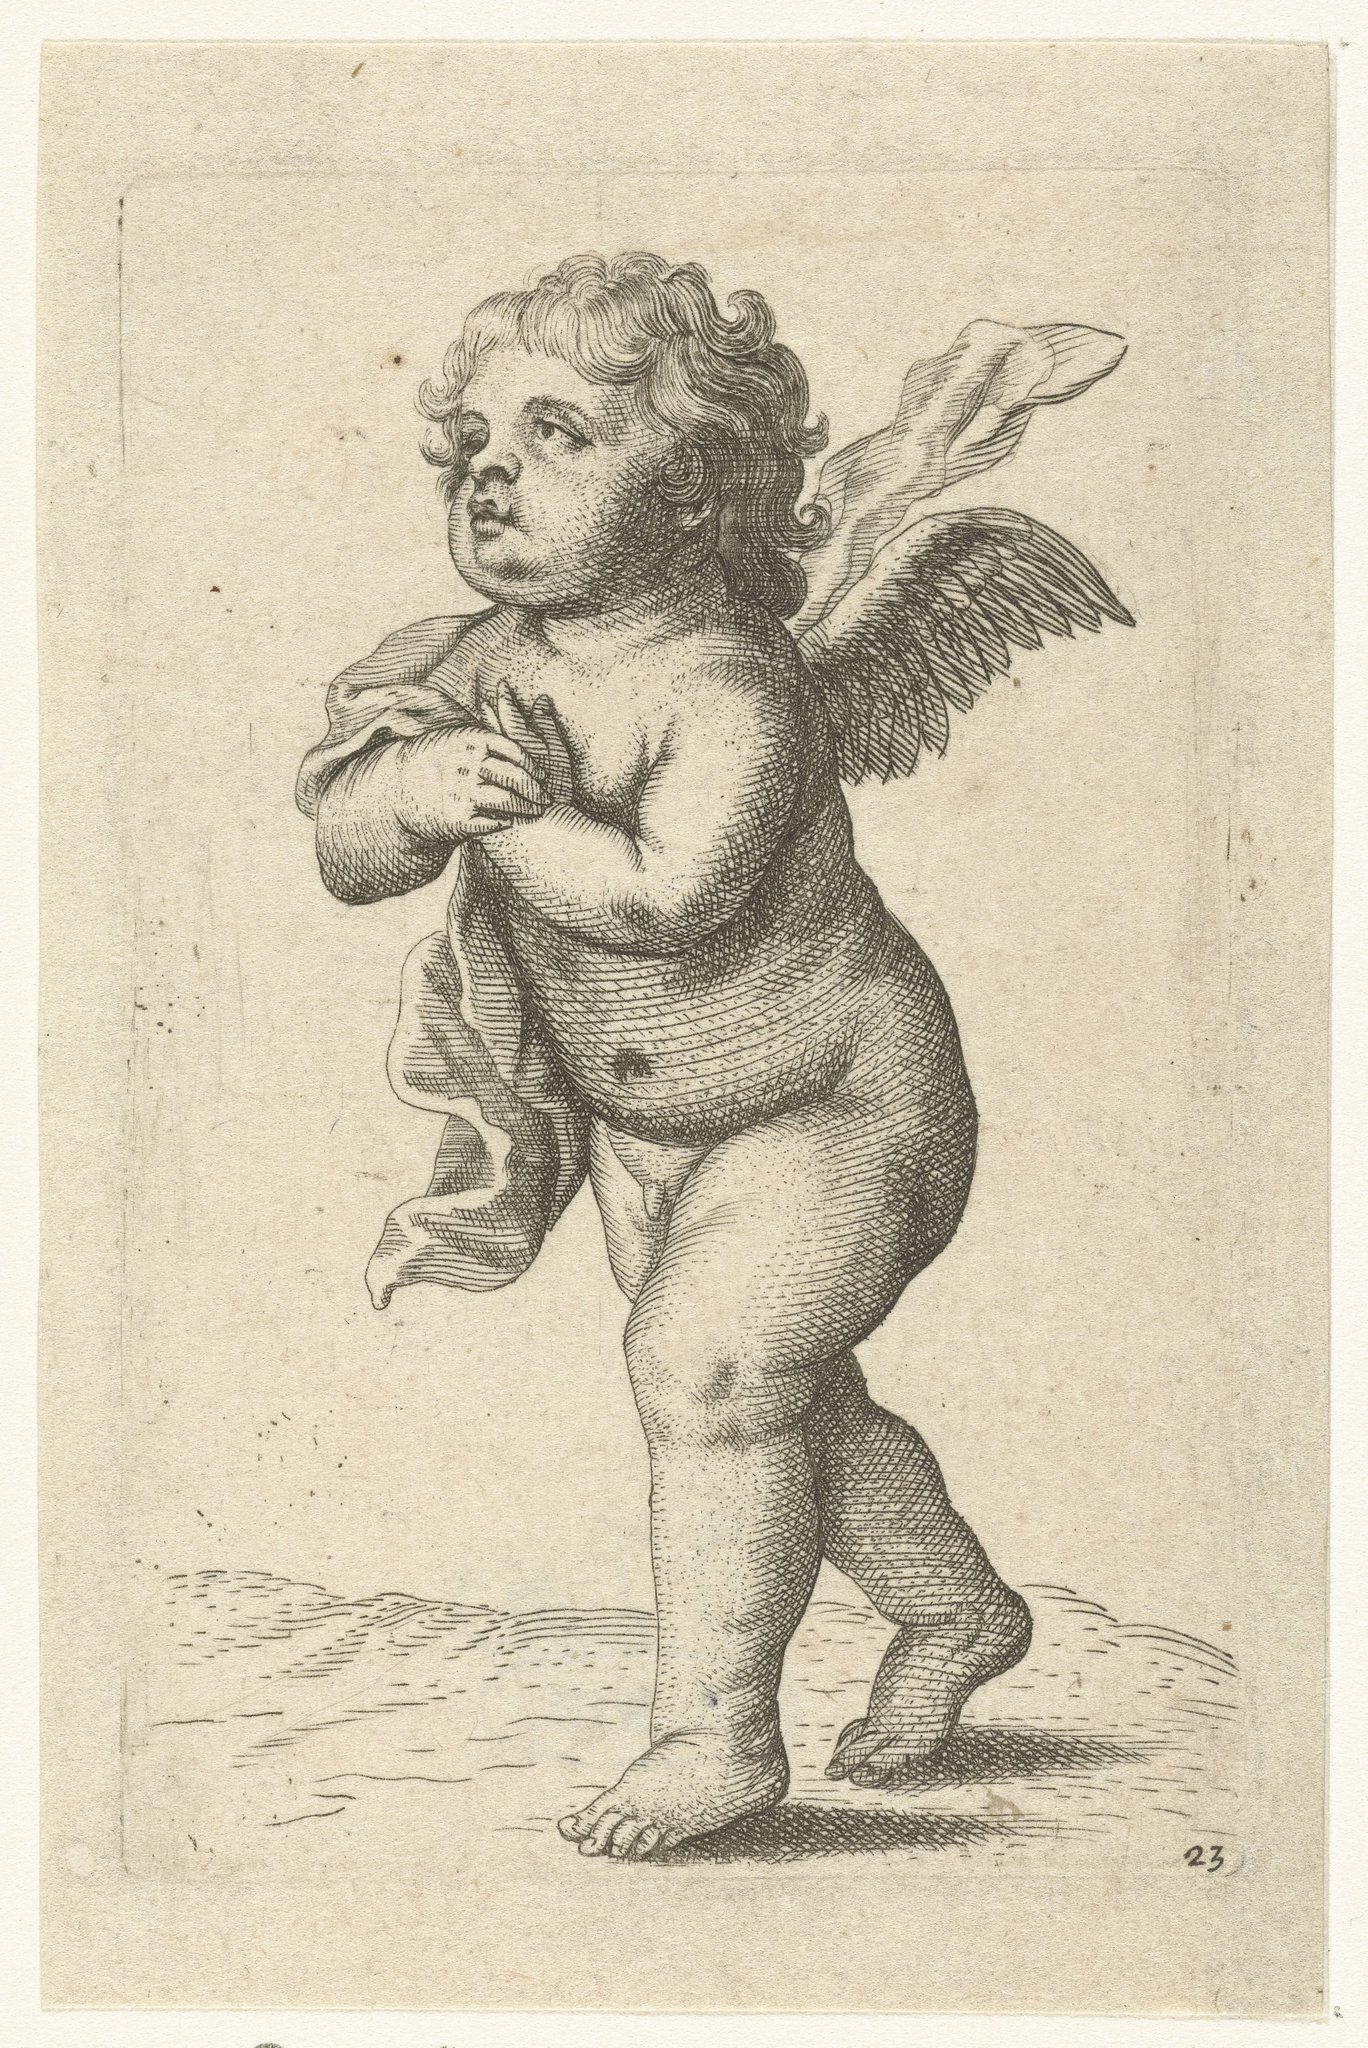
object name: print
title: Lopend engeltje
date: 1630-1652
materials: paper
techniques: engraving, etching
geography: amsterdam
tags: angels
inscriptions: collector's mark: Lugt 2228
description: Lopend engeltje. Prent uit een serie van 24 prenten met engelen of kinderen.